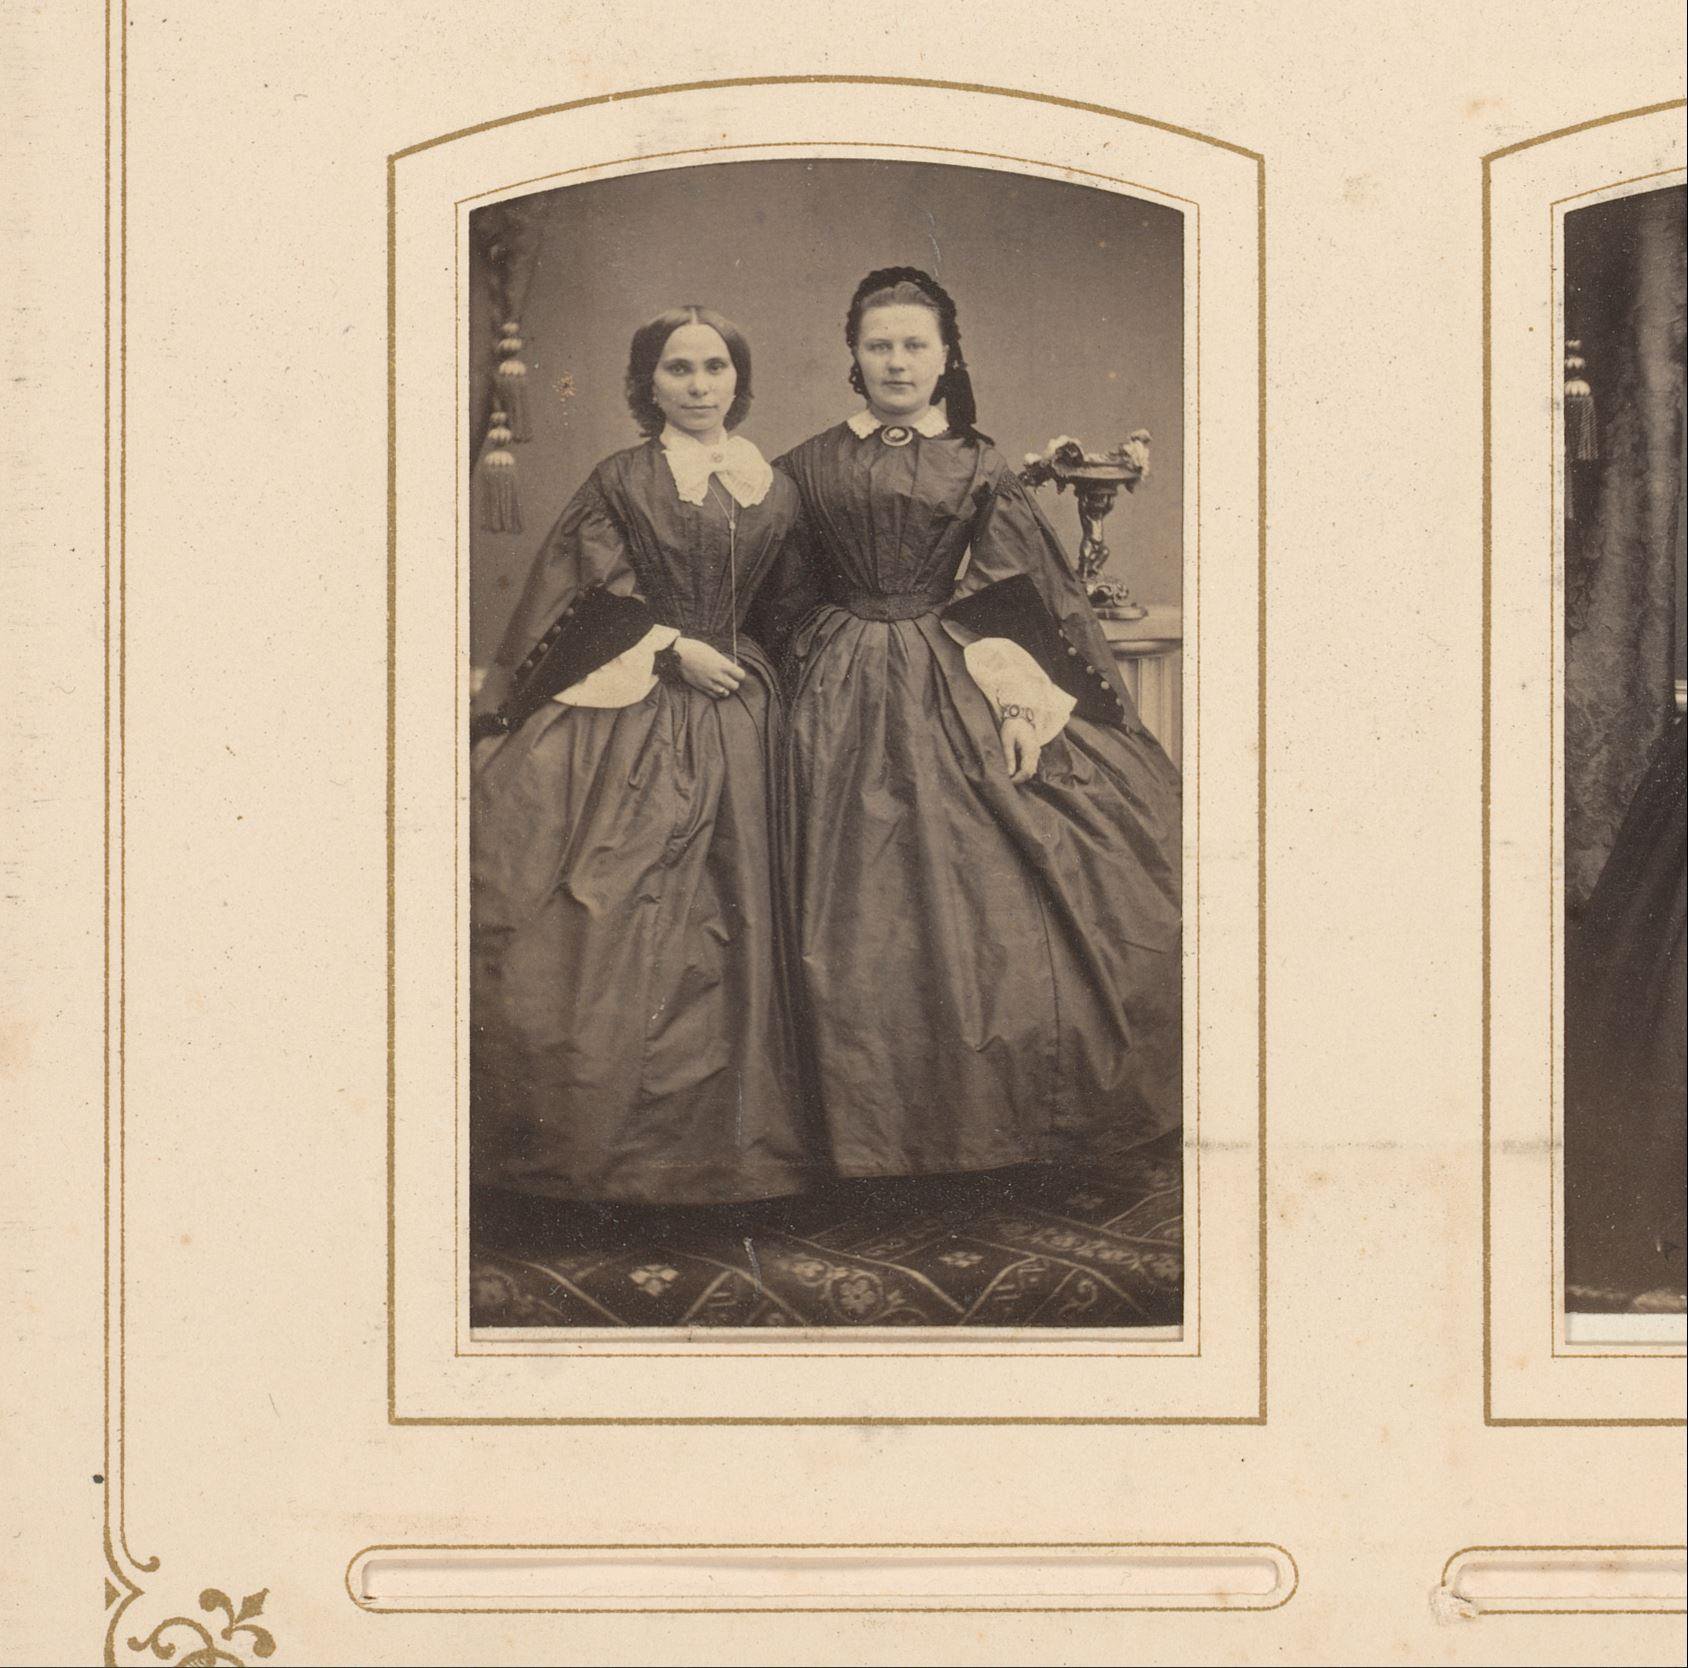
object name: photograph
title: Portret van twee vrouwen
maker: th. schütz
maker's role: fotograaf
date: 1850-1900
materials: cardboard, photographic support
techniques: albumen print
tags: historical persons - bb - woman, adult woman (+ two persons)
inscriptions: inscription: ‘TH. SCHÜTZ/ PHOTOGRAPH.’